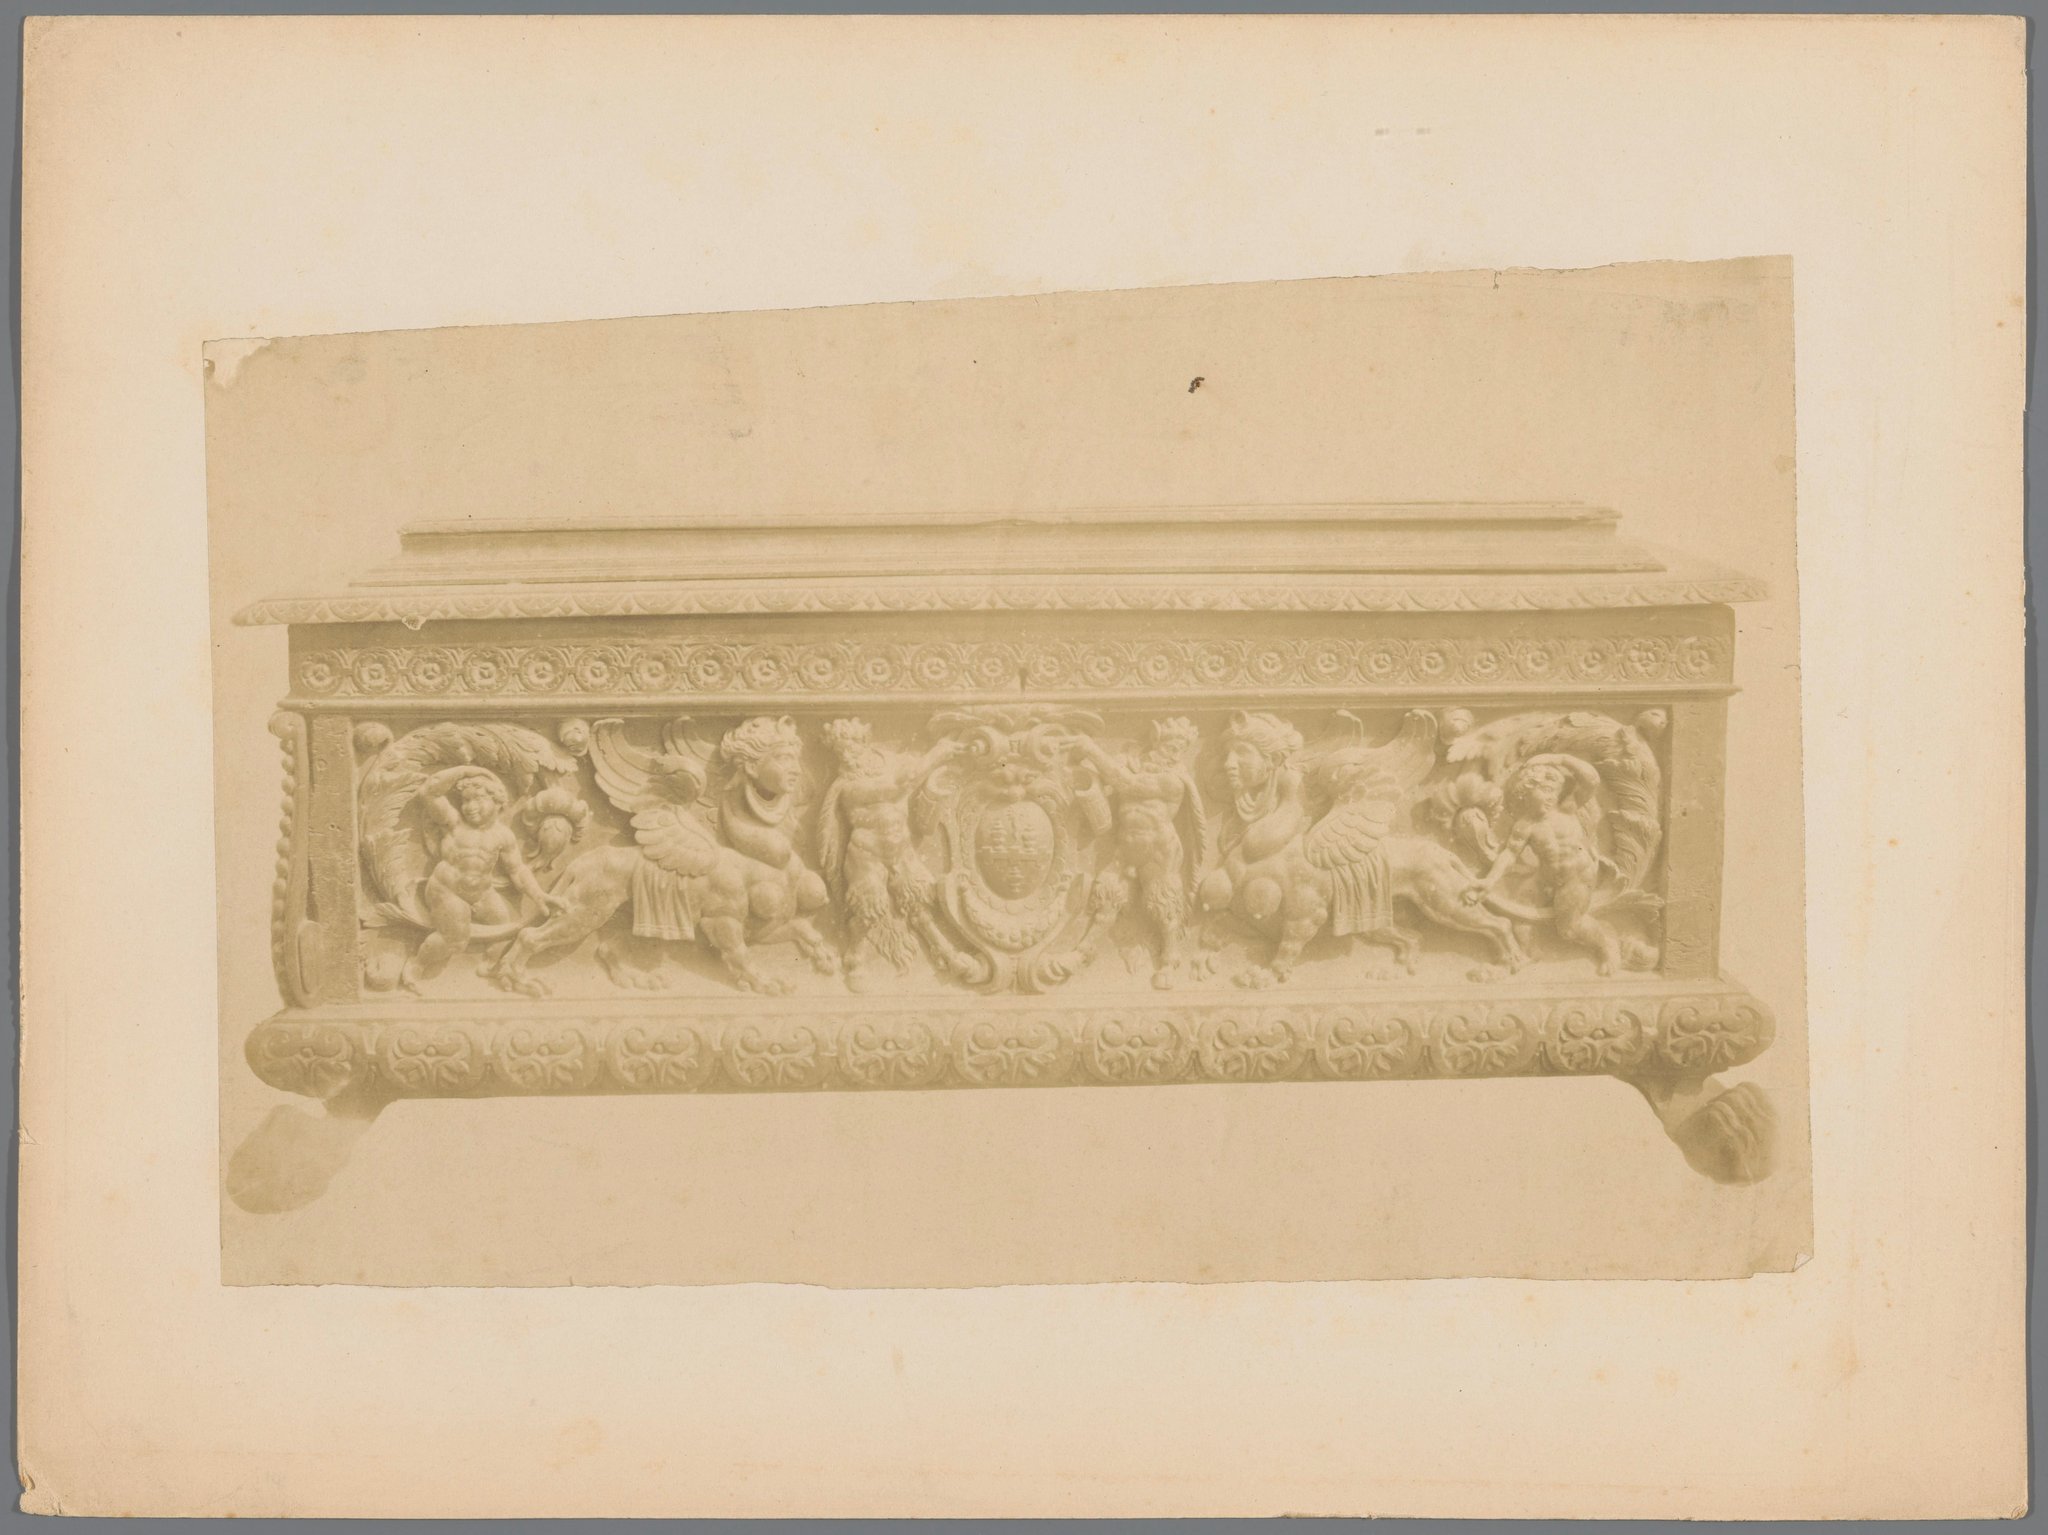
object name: photograph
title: Kist met een reliëf van sfinxen en saters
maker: Anonymous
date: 1875-1900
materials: cardboard, photographic support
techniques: albumen print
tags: sphinx (lion/woman); 'sfinge' (ripa) - aa - female human figure, satyr(s) (in general), chest, coffer, sculpture (+ relief ~ sculpture)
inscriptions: collector's mark: Lugt 3937